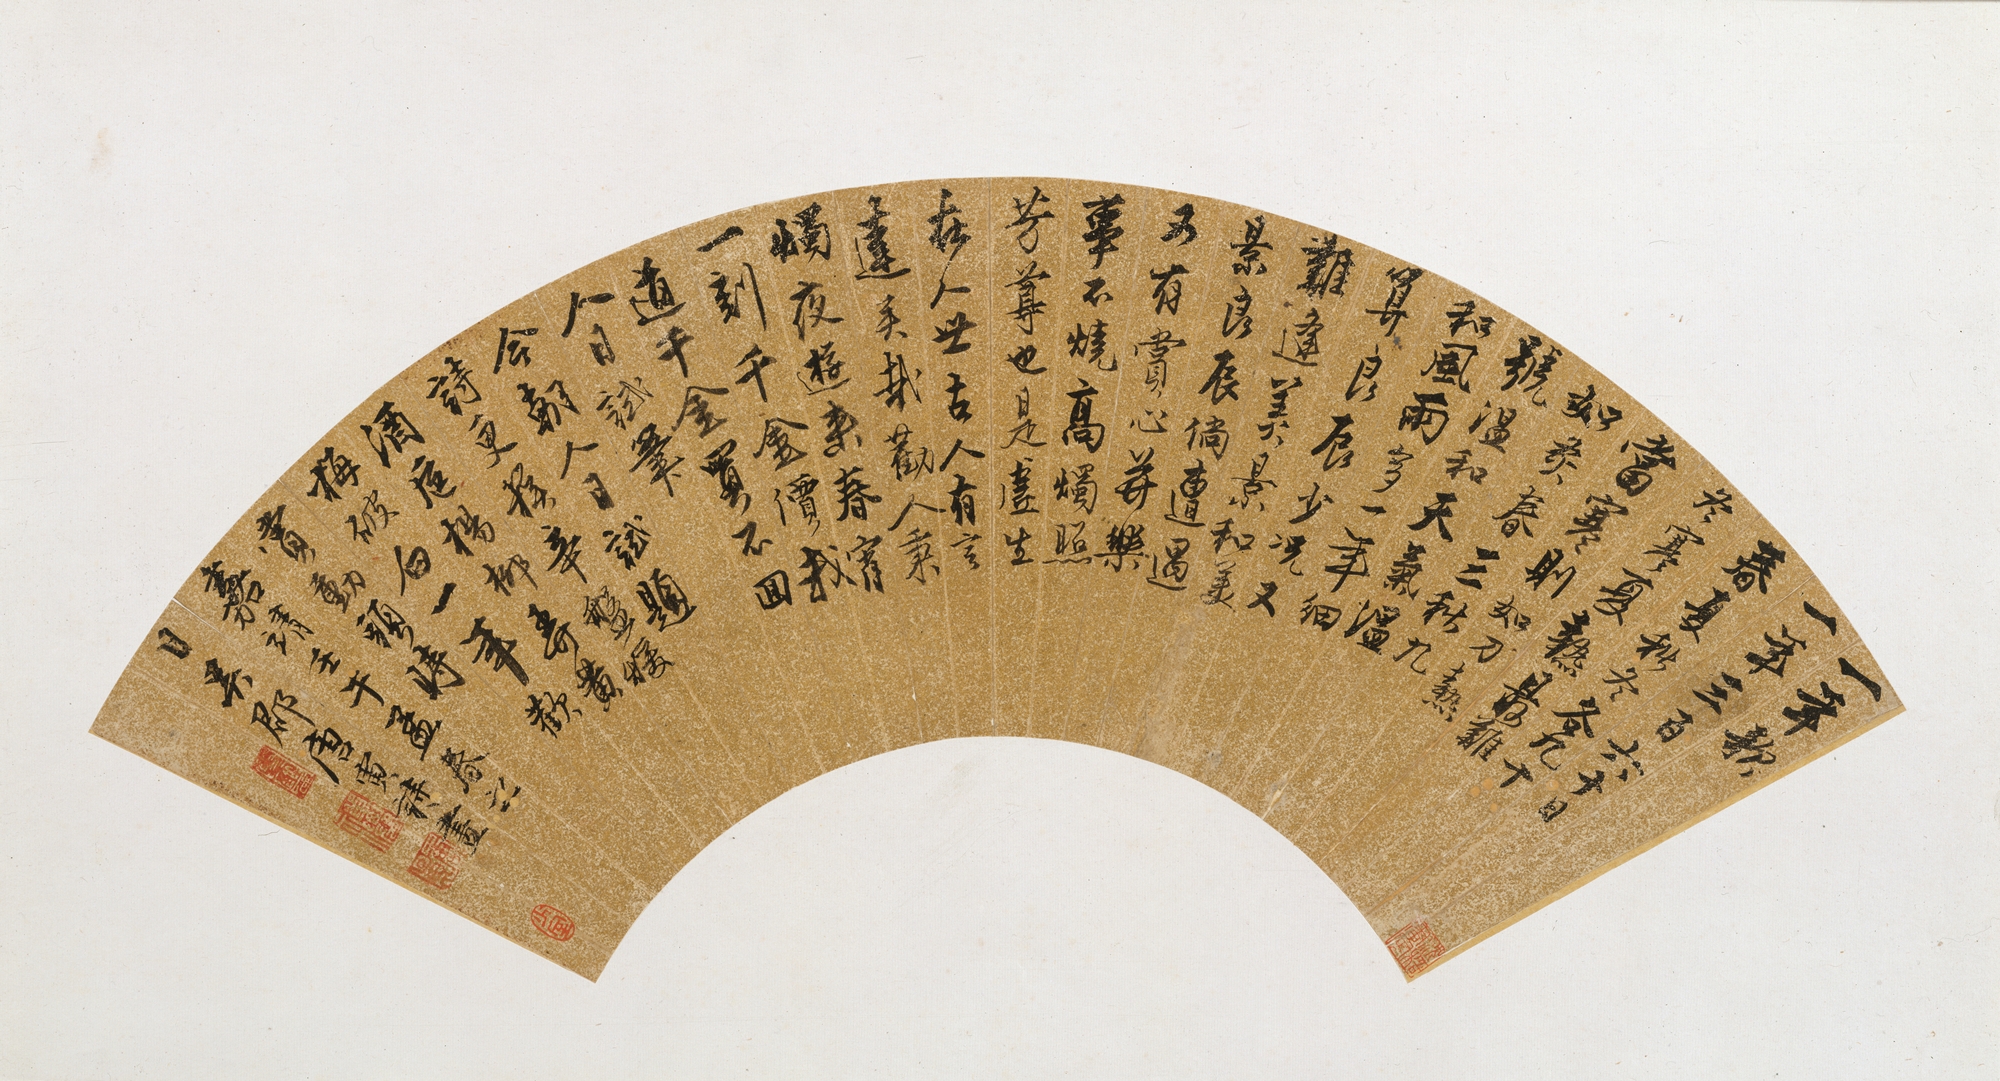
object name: folding fan mounted a an album leaf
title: Song of One Year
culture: chinese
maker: tang yin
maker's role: artist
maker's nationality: chinese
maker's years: 1470-1524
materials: gold, ink, paper